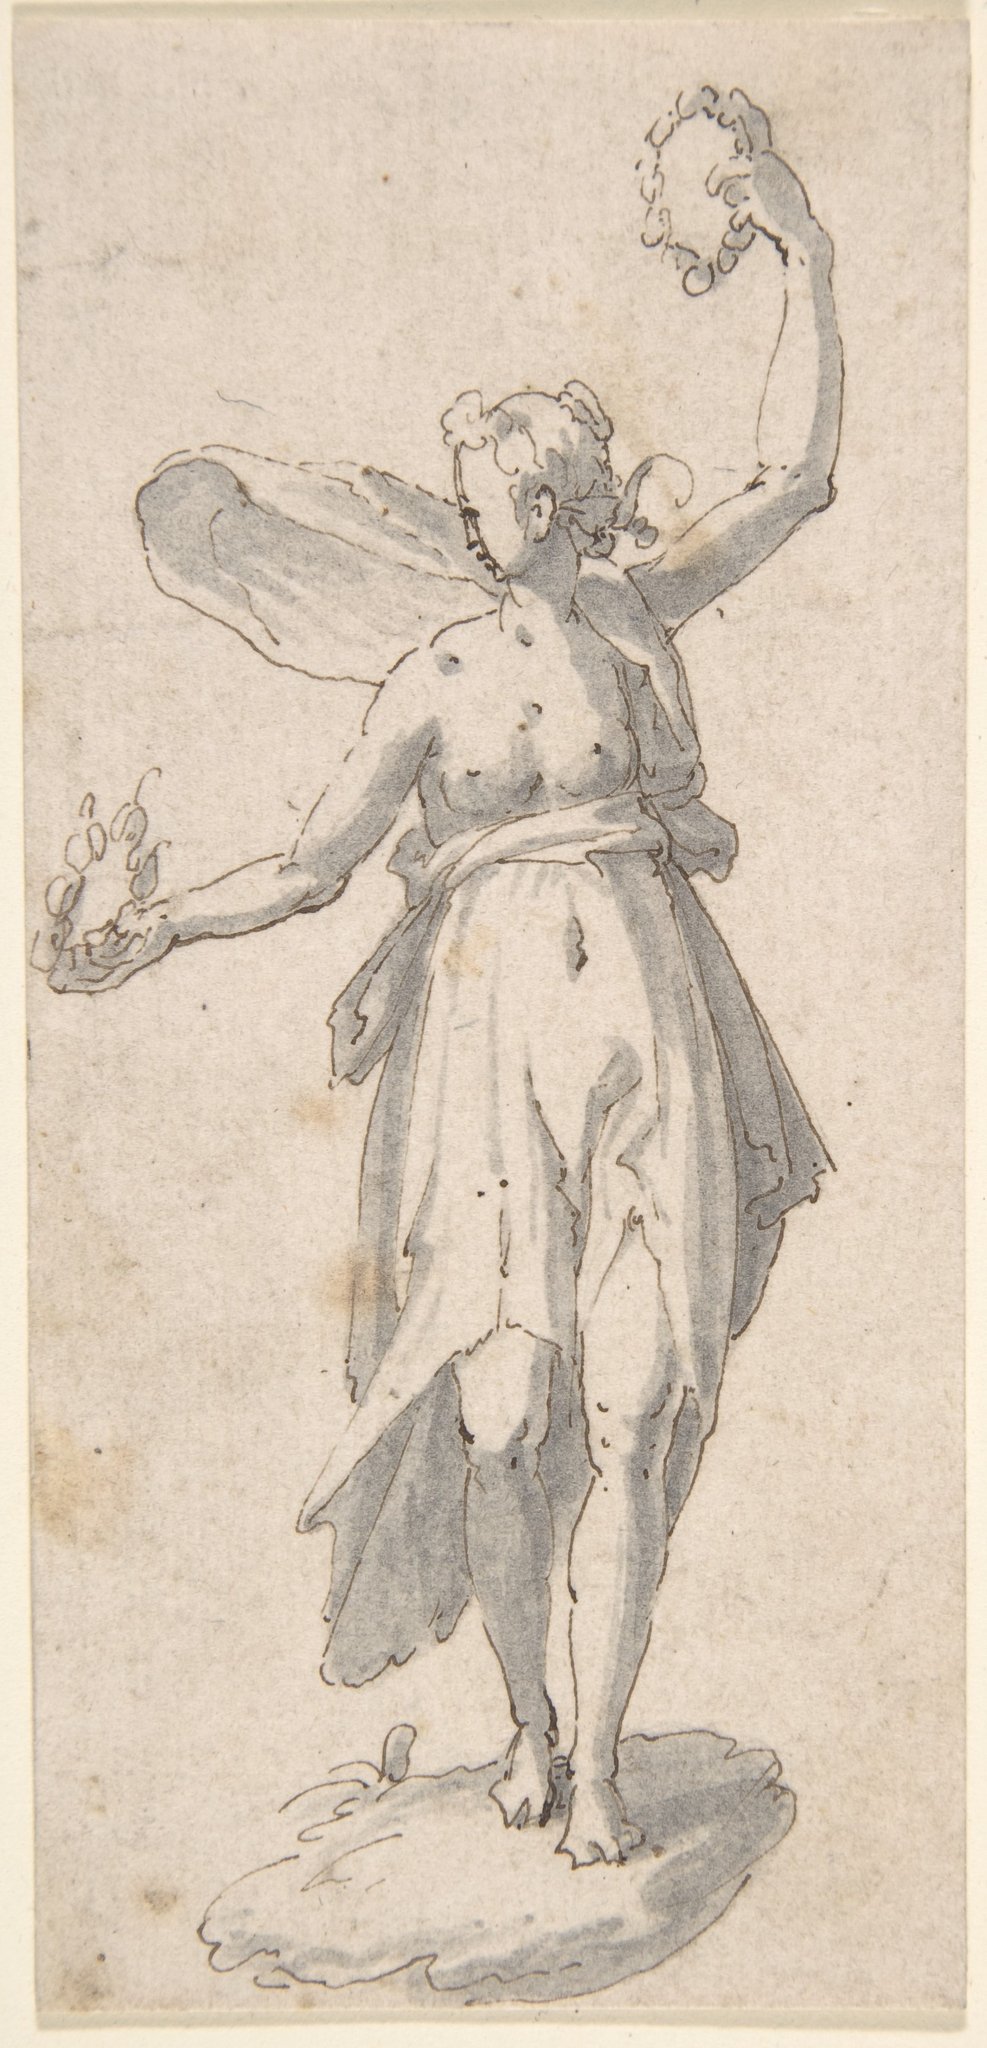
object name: drawing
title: Female Figure Holding Wreaths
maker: anonymous, italian, 17th century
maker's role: artist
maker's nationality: italian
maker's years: 1600-1700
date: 1601-1700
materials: ink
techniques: brush, pen, wash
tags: female nudes,wreaths